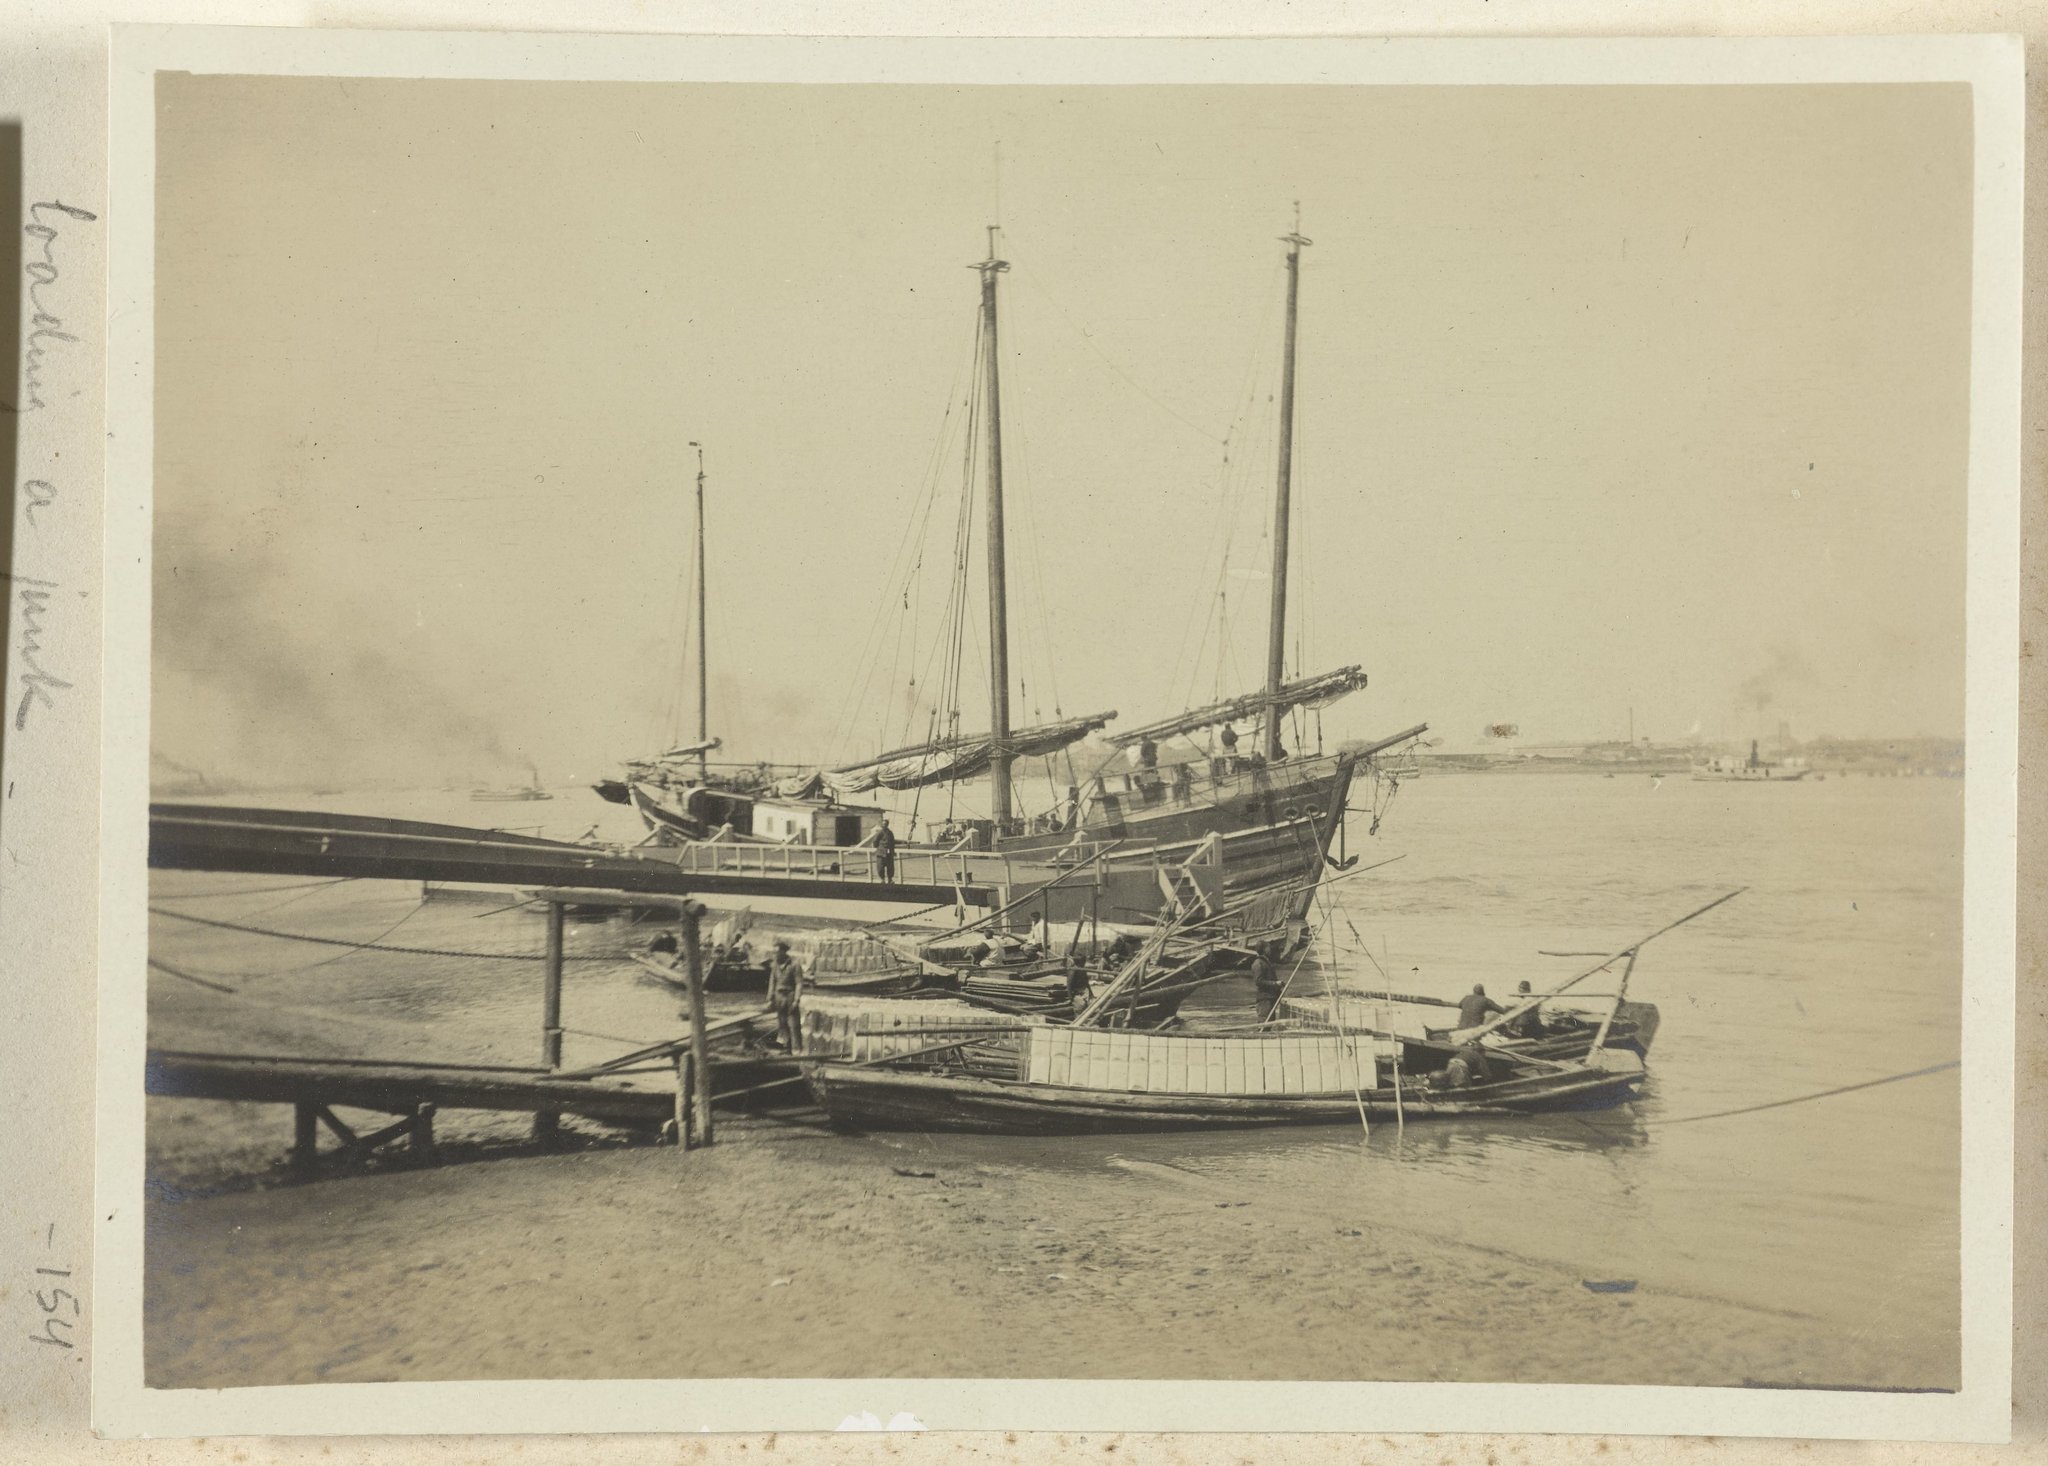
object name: photograph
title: Loading a junk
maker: geldolph adriaan kessler (dolph)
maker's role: fotograaf, industrieel, voetballer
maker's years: 1884-1945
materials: cardboard, photographic support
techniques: gelatin silver print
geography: shanghai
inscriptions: title: ‘Loading a junk’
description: Het inladen en bevoorraden van een jonk in de haven van Shanghai. Onderdeel van het fotoalbum van Dolph Kessler met opnamen die hij maakte tijdens zijn verblijf in Engeland en op een wereldreis die hij als secretaris van Henri Deterding (directeur Koninklijke Olie) ondernam naar Nederlands-Indië, Japan, China en de Verenigde Staten, tussen 1906 en 1908.